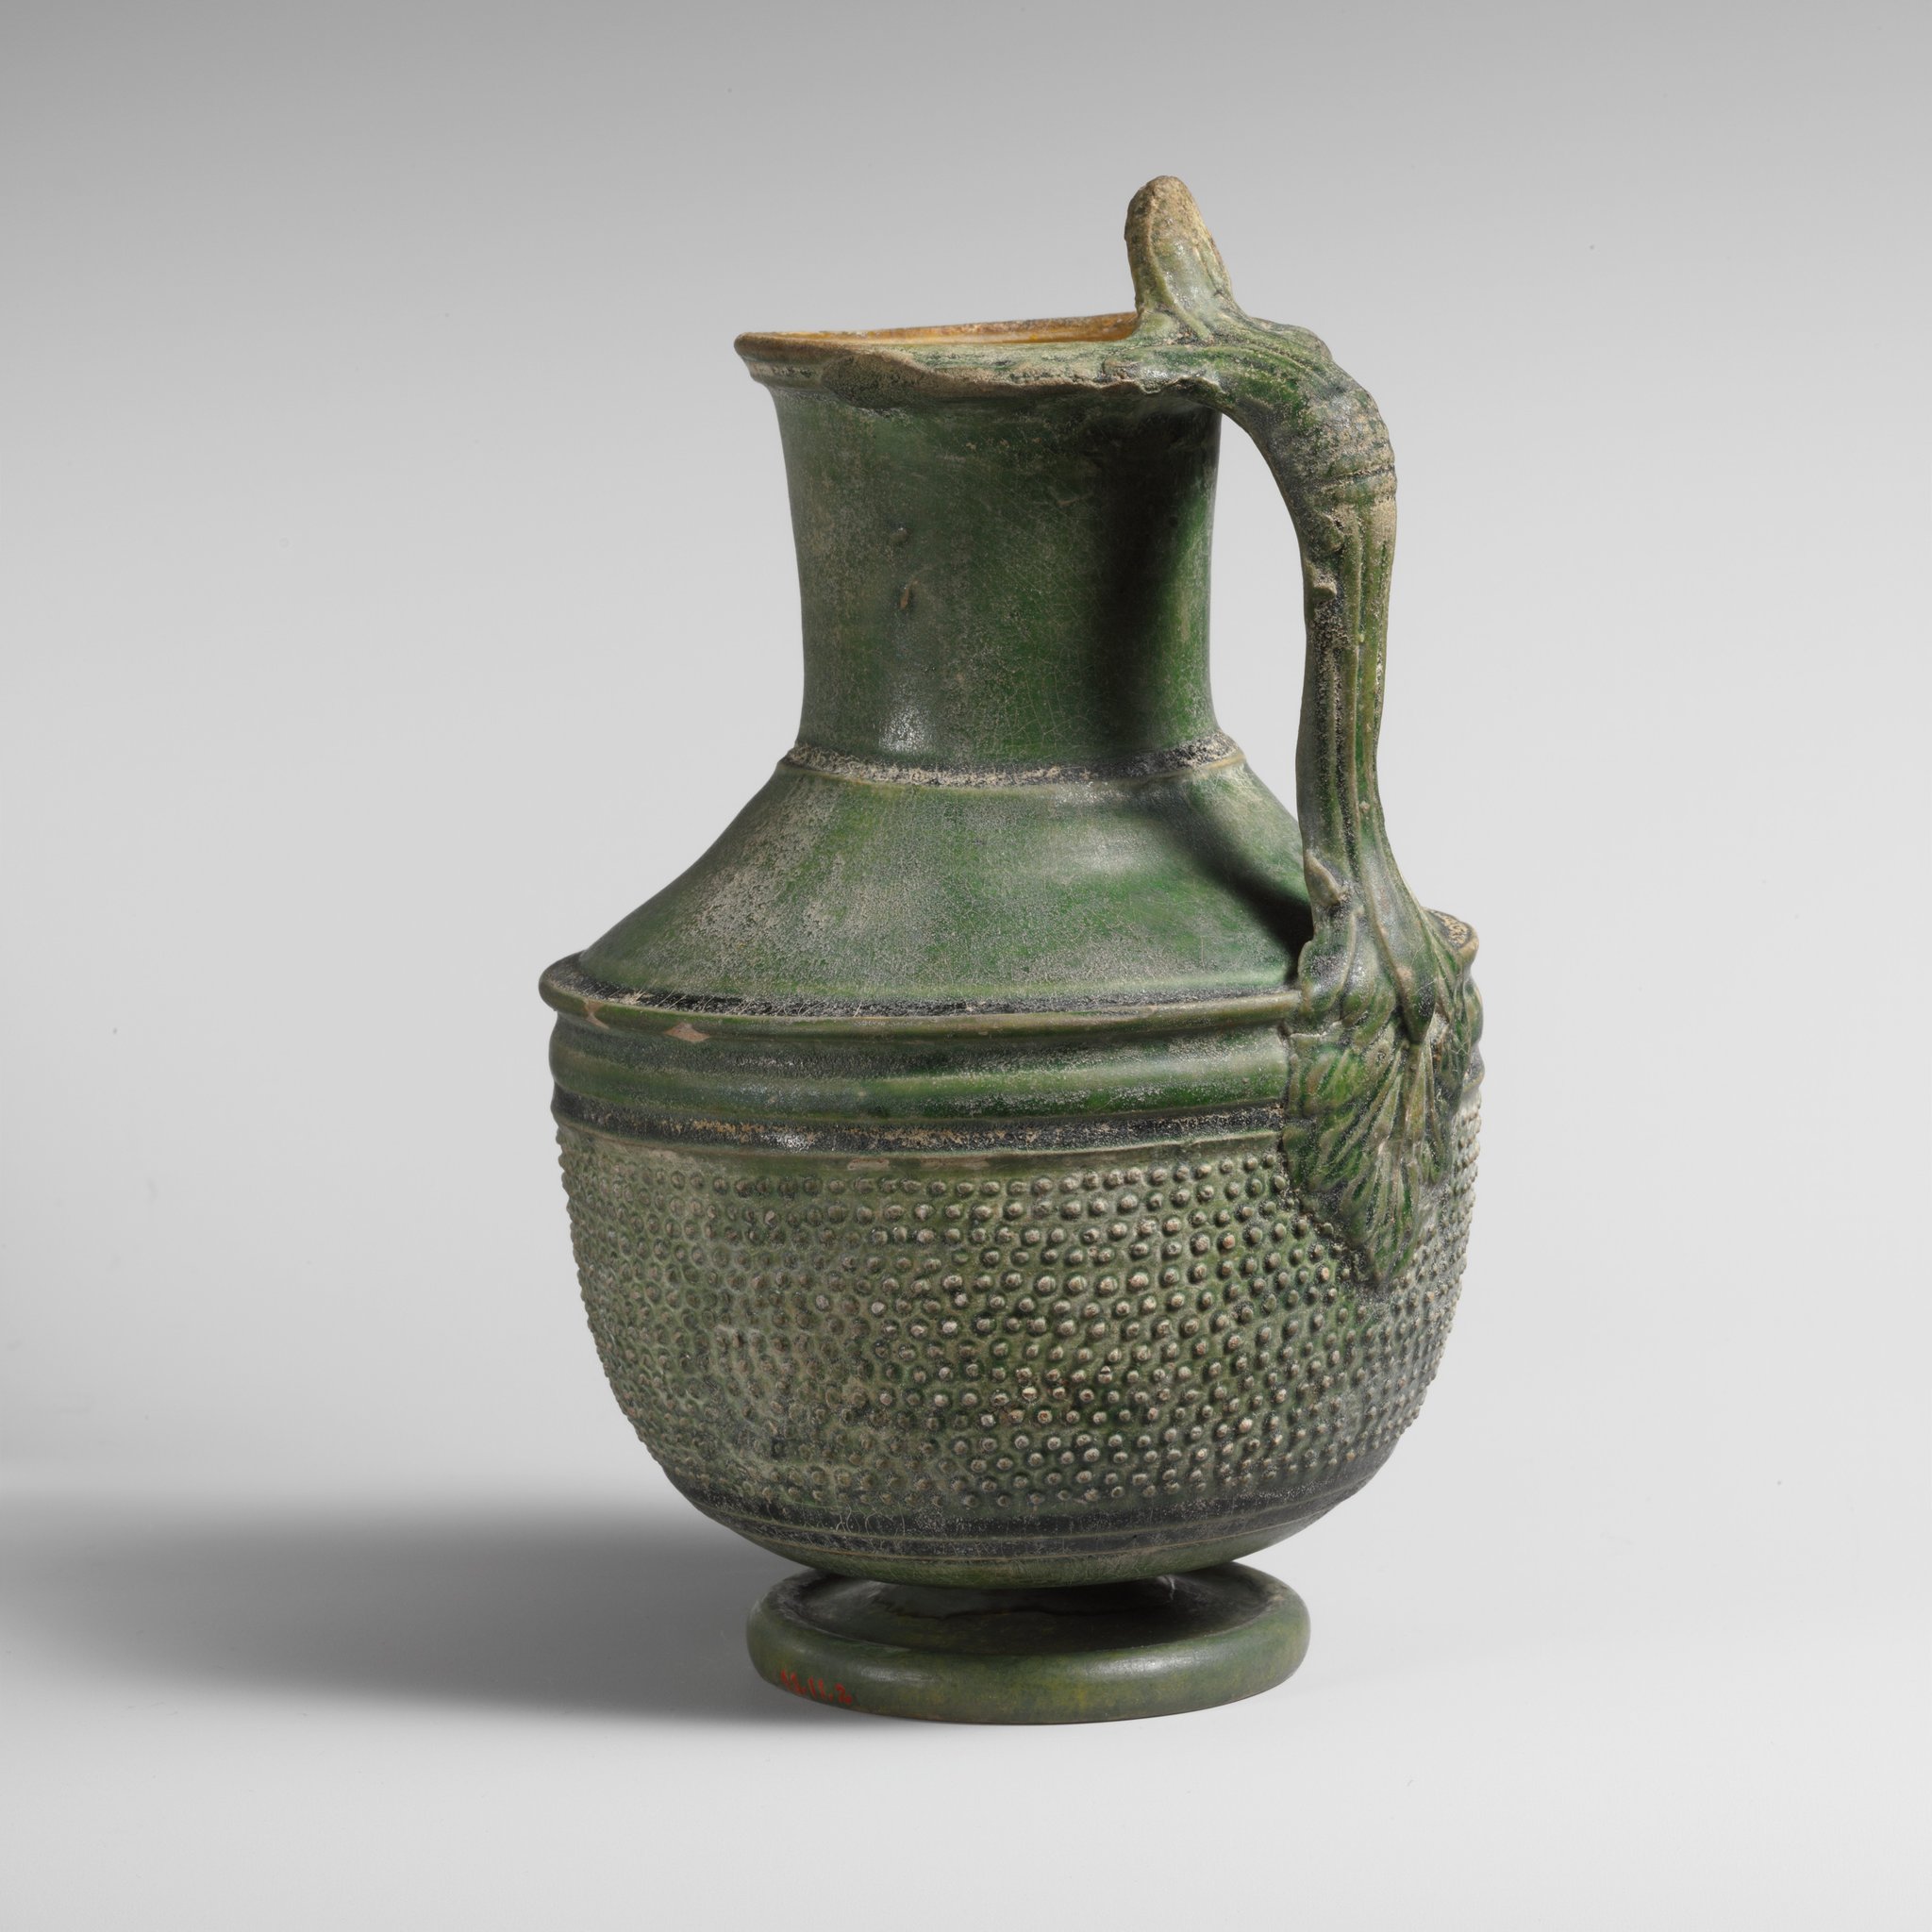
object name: jug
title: Terracotta jug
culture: roman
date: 1-50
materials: terracotta